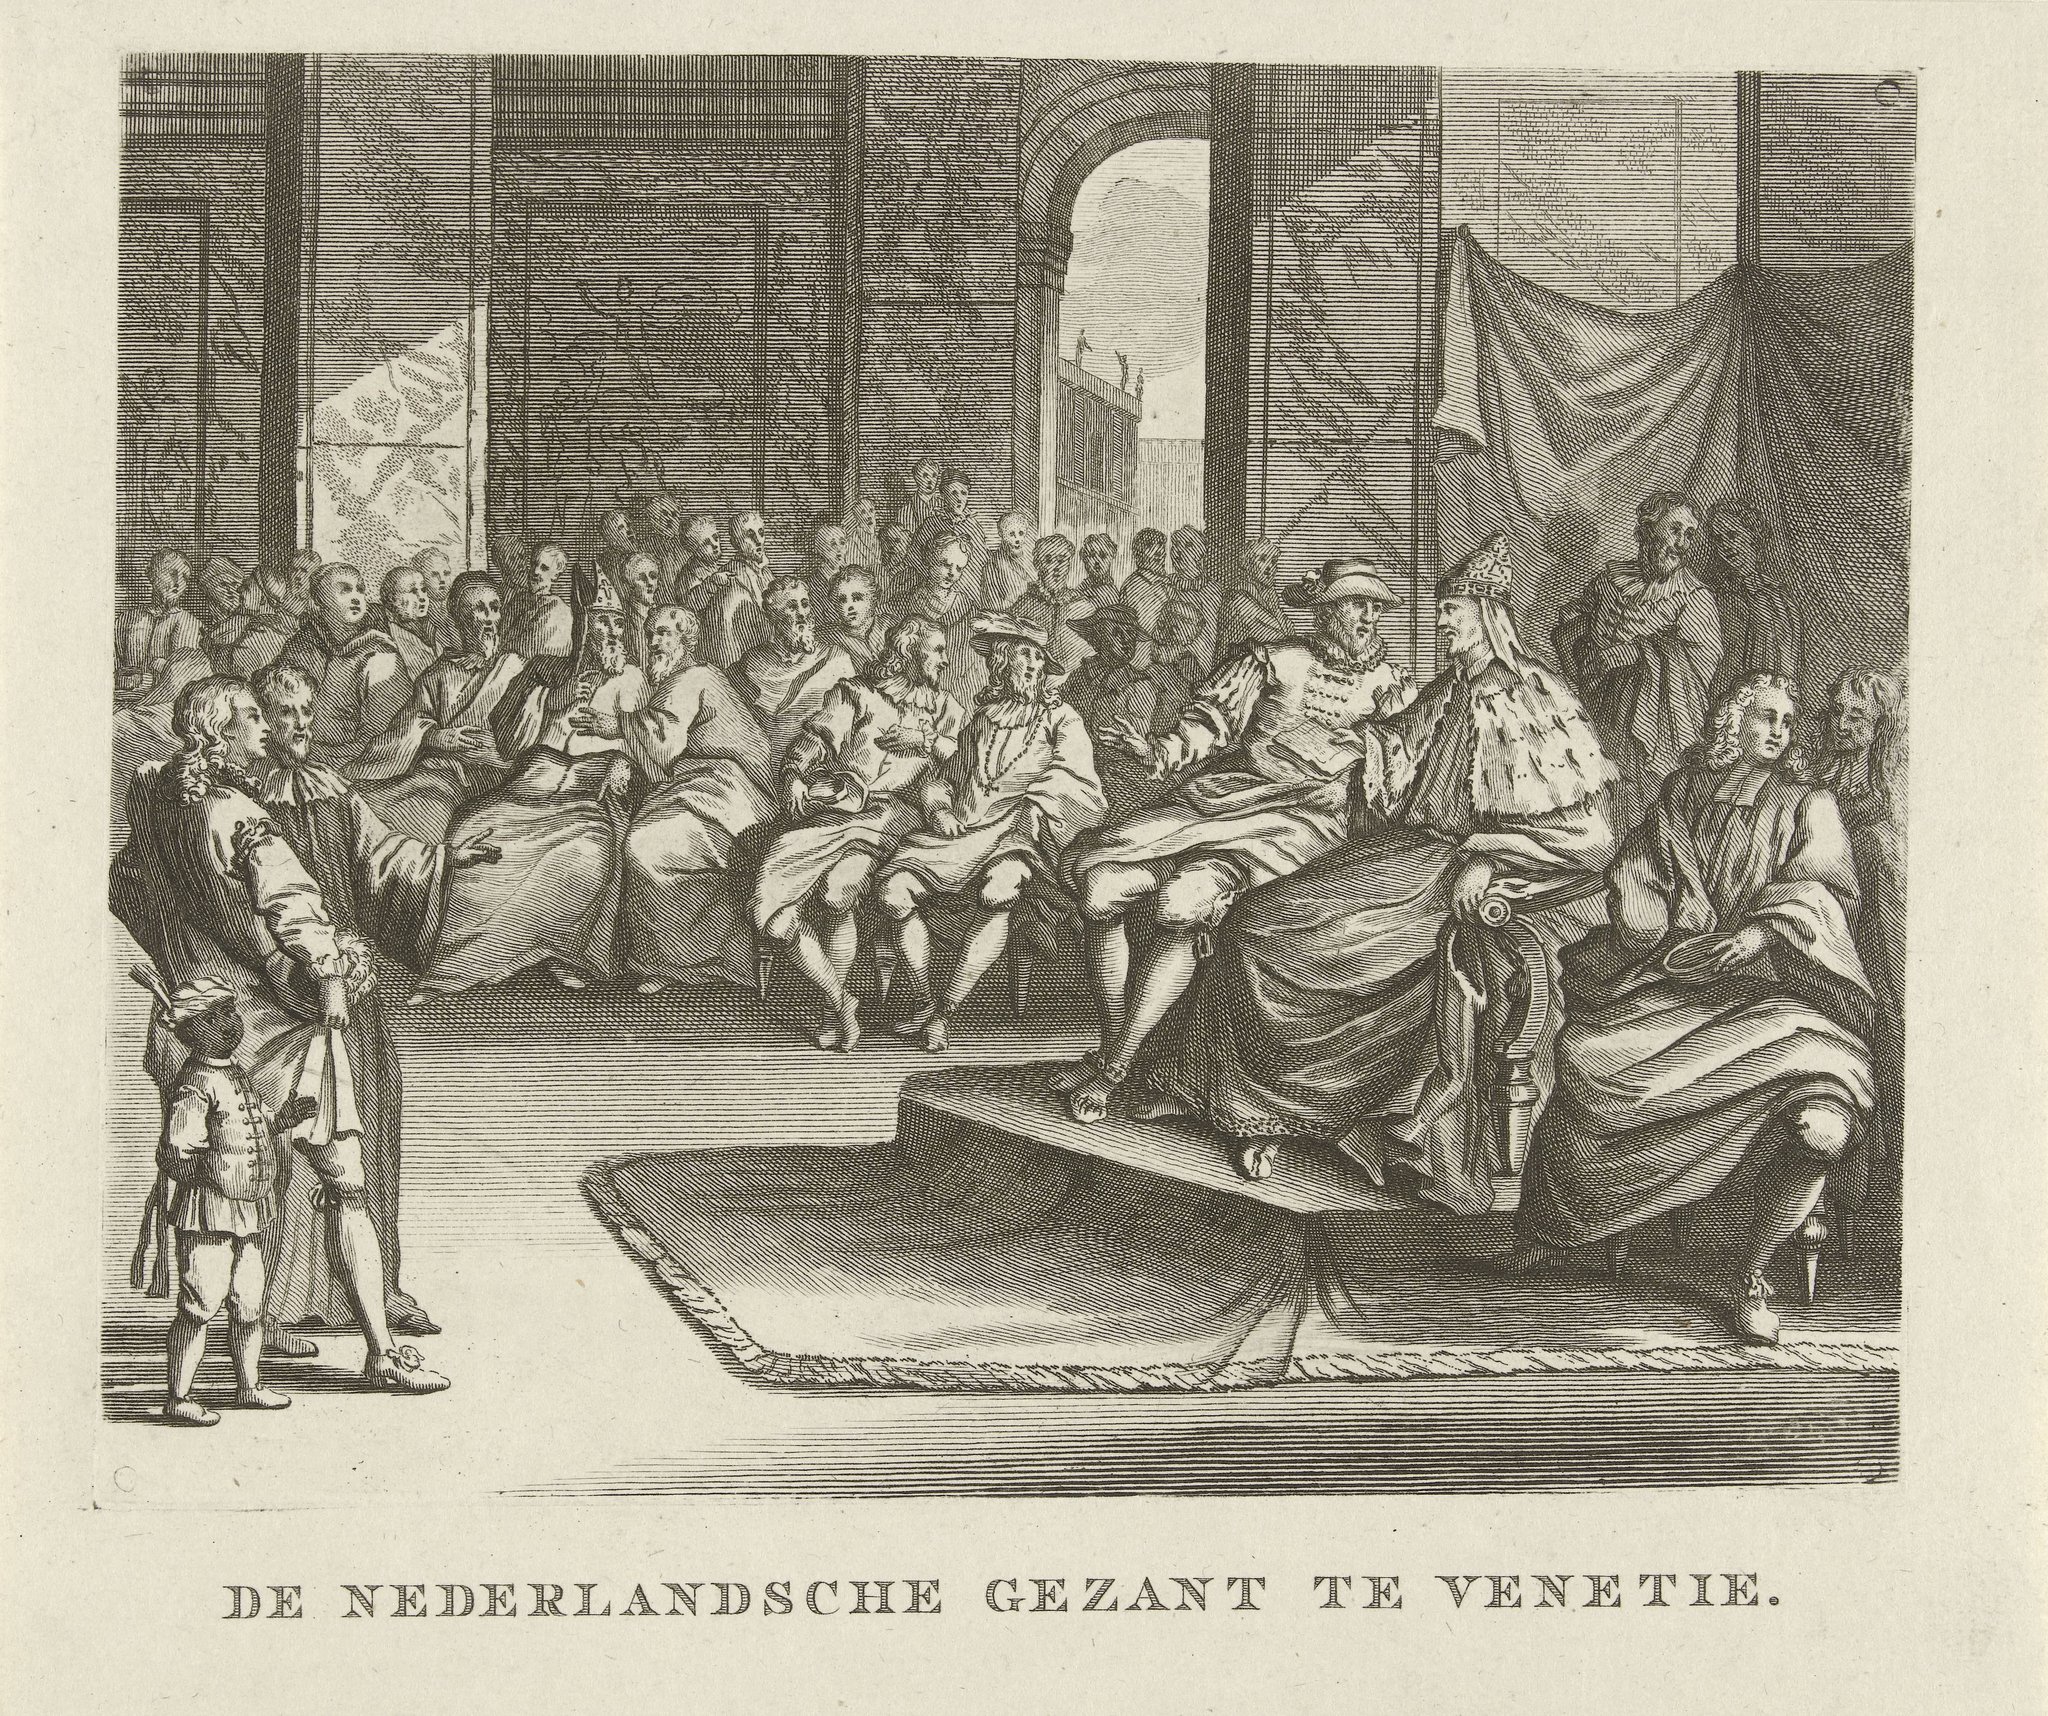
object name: print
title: De Nederlandse gezant te Venetië, ca. 1561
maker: matthijs pool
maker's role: print maker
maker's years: 1676-1740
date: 1700-1740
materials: paper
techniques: engraving, etching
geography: northern netherlands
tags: audition; ruler giving audience, venice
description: De Nederlandse gezant te Venetië, ca. 1561. Gelegenheid waarbij voor het eerst de vertegenwoordiger van de Staten als Heeren Staten begroet werd. Ontvangstruimte met de gezant zittend naast de doge op een podium.